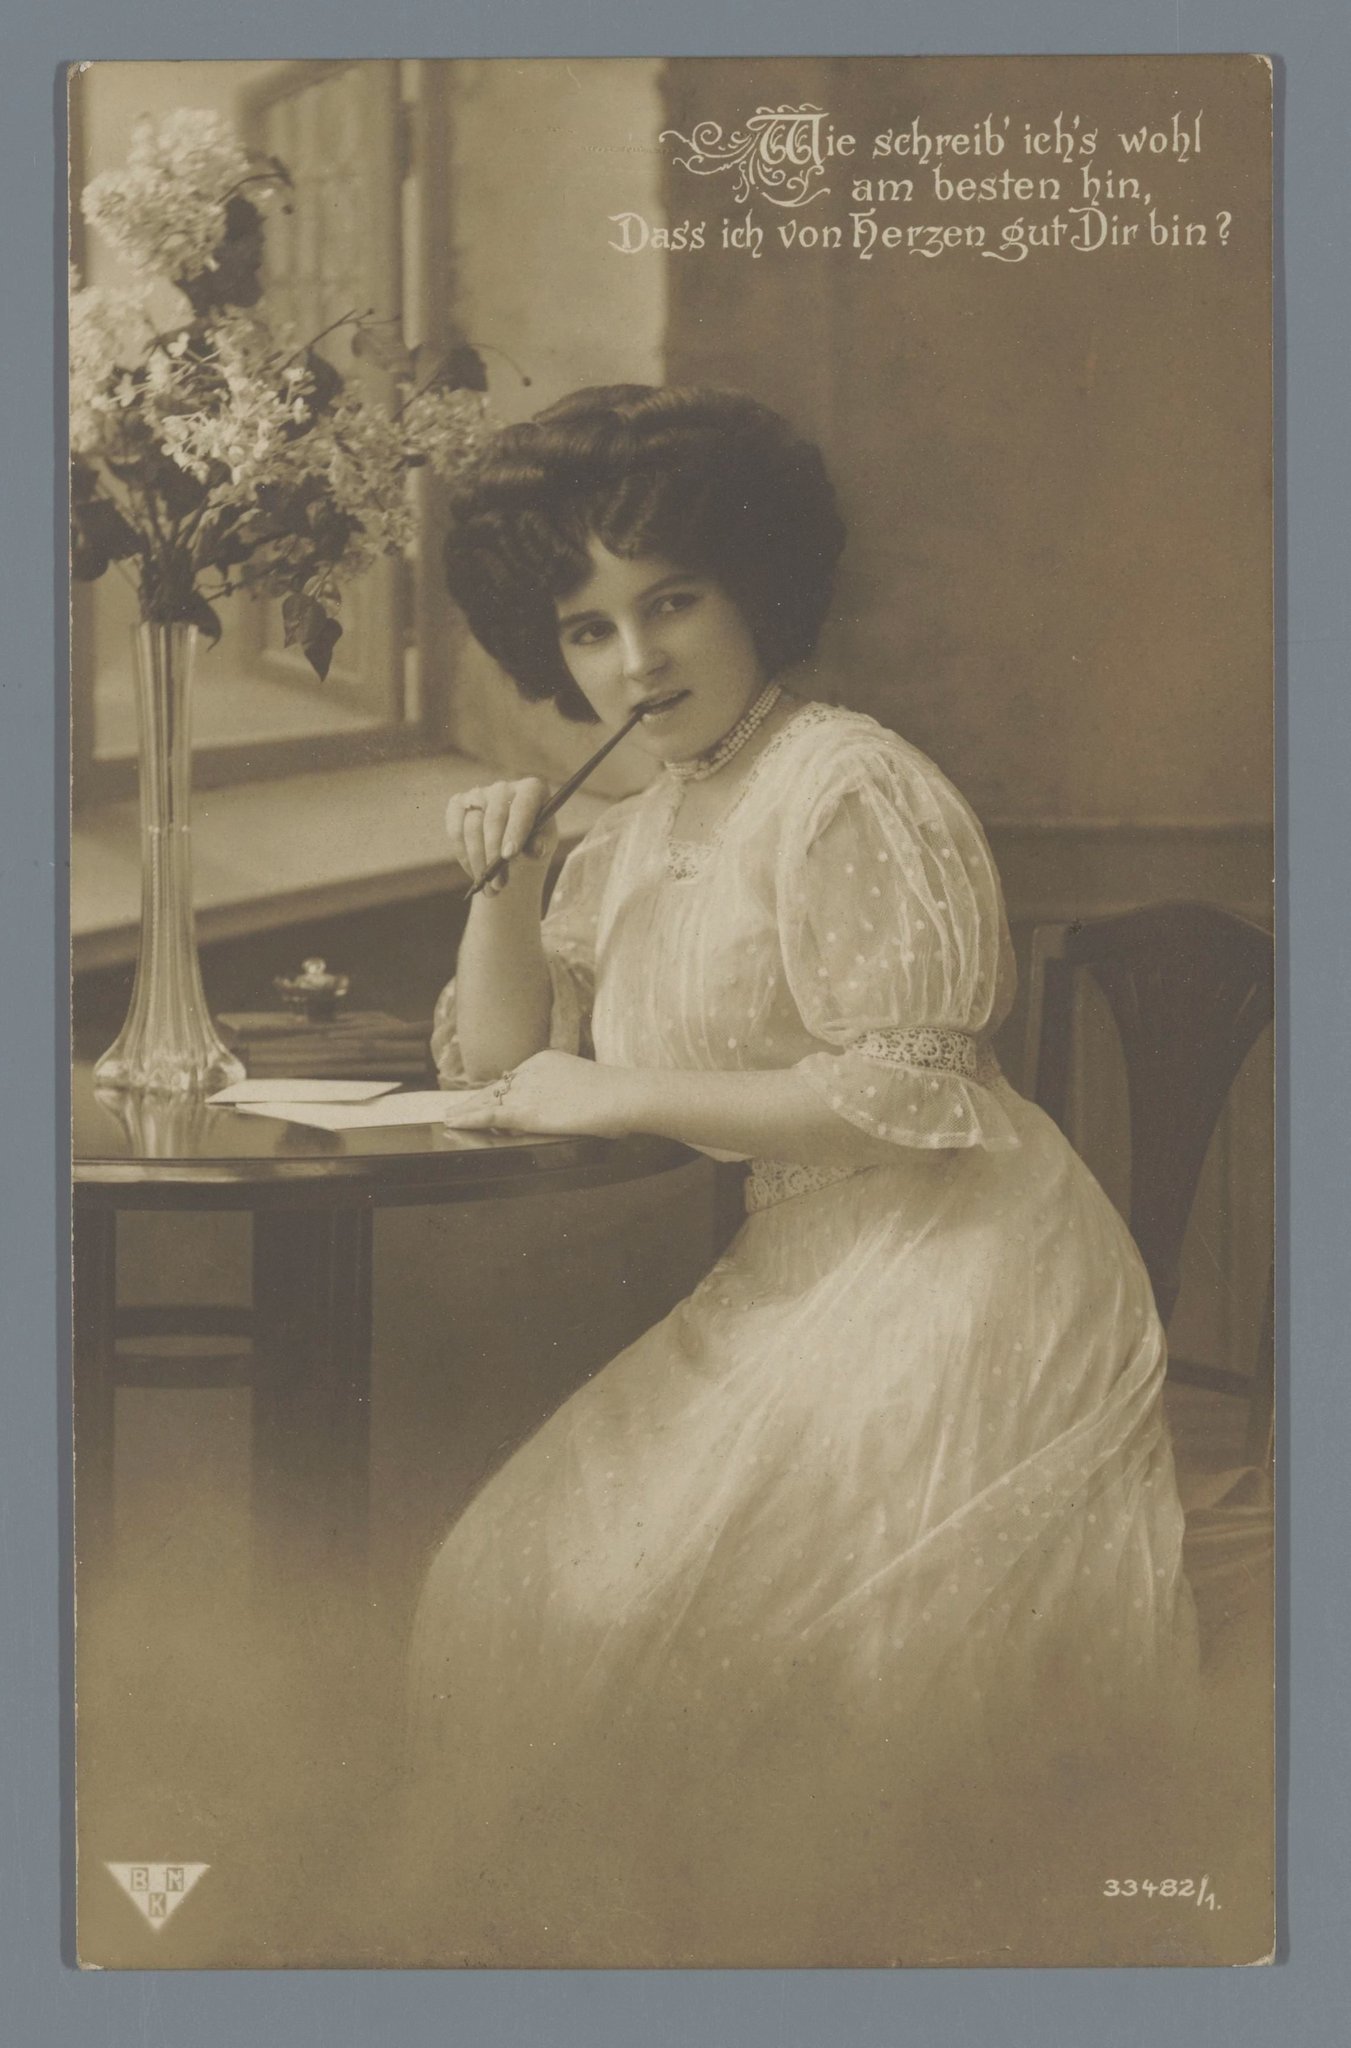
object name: ansichtkaart, prentbriefkaart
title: Portret van een onbekende vrouw aan een schrijftafel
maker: Anonymous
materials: photographic support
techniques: gelatin silver print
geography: germany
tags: writing-table, writing-desk, adult woman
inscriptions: inscription: ‘Von (...) I Etage’, inscription: ‘Wie schreib' ich's wohl am besten hin, Dass ich von Herzen gut Dir bin?’, inscription: ‘BKK’, number: ‘33482/1’, inscription: ‘Bremen 27. 4 10 1-2N’